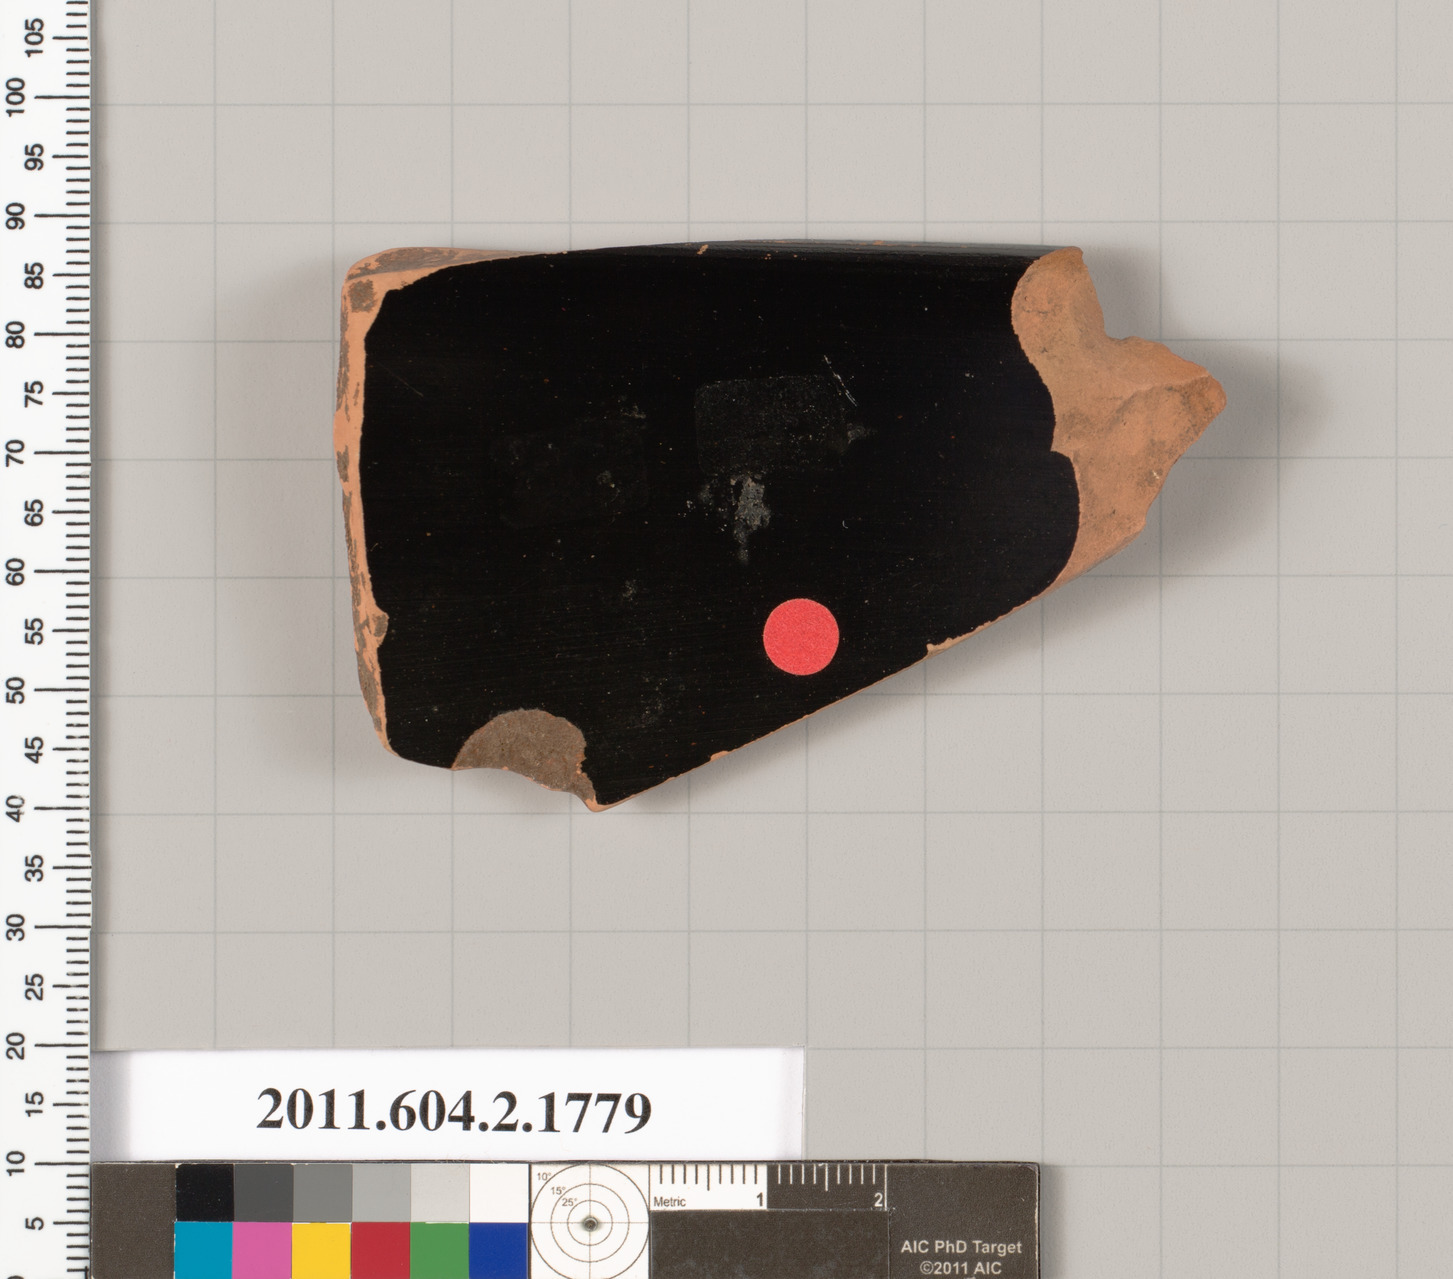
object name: skyphos fragment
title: Terracotta rim fragment of a skyphos (deep drinking cup)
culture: greek, attic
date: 460-440 BCE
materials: terracotta